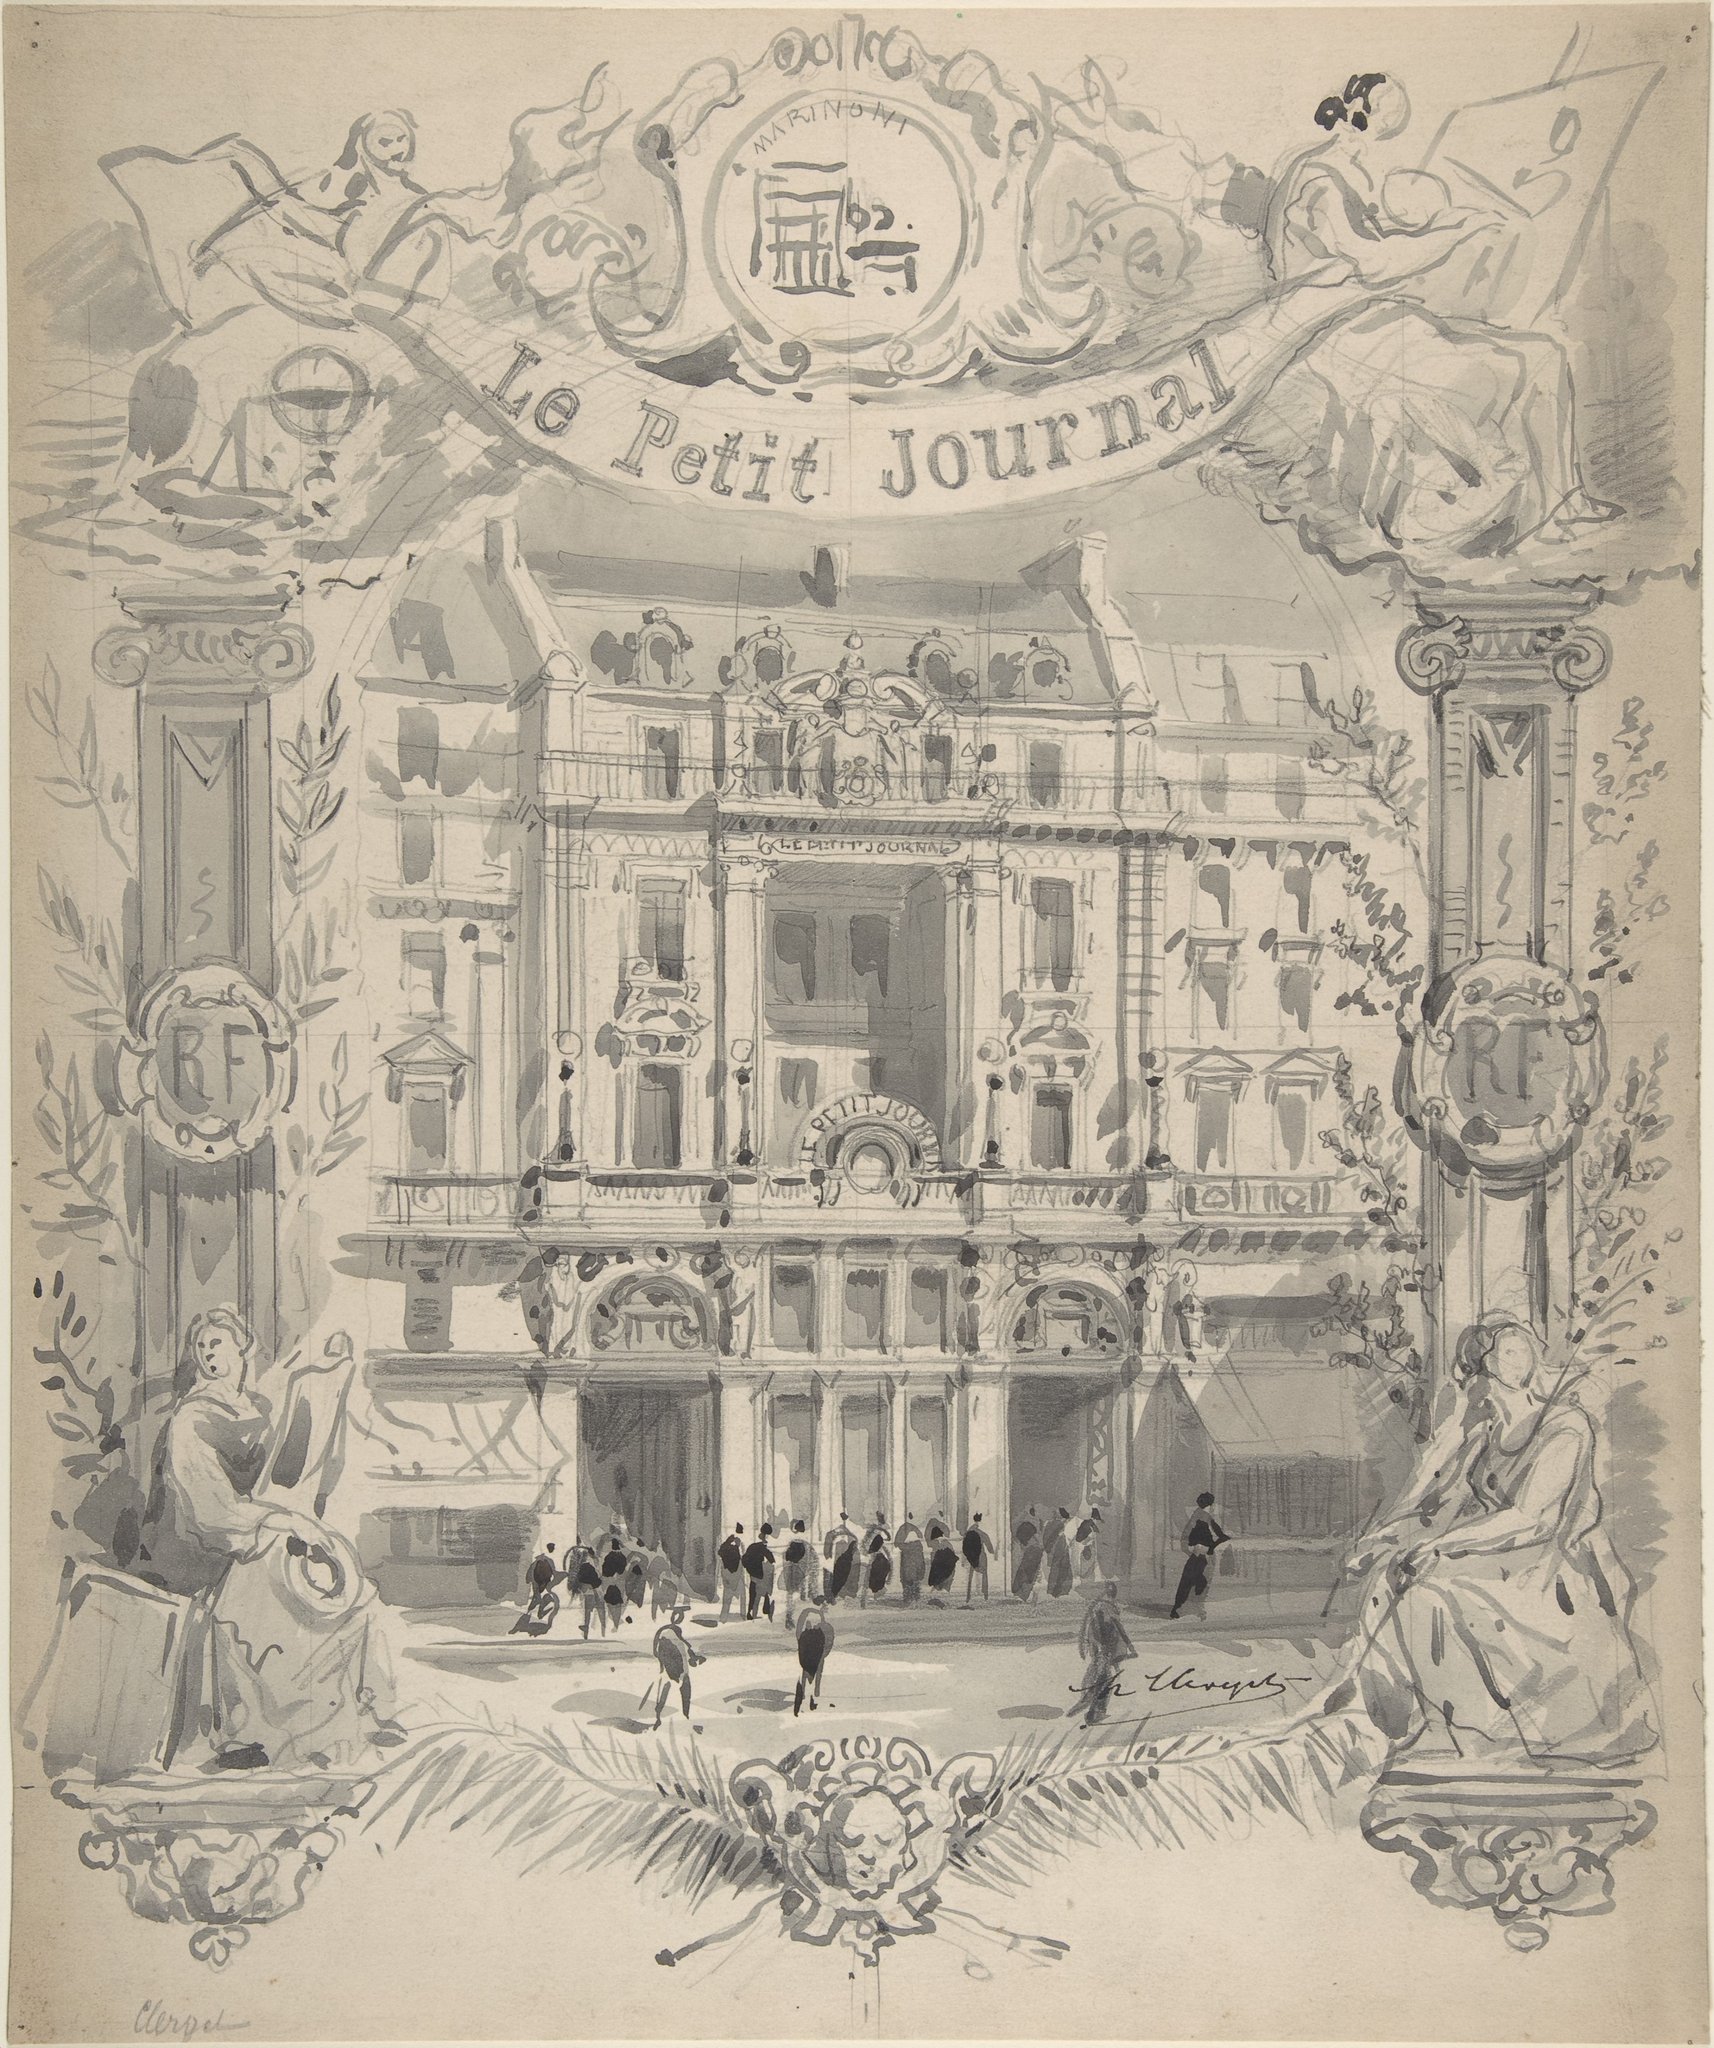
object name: drawing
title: Drawing for title page "Le Petit Journal"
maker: hubert clerget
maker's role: artist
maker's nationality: french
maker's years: 1818-1899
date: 1801-1900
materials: graphite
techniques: brush, drawing, wash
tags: buildings